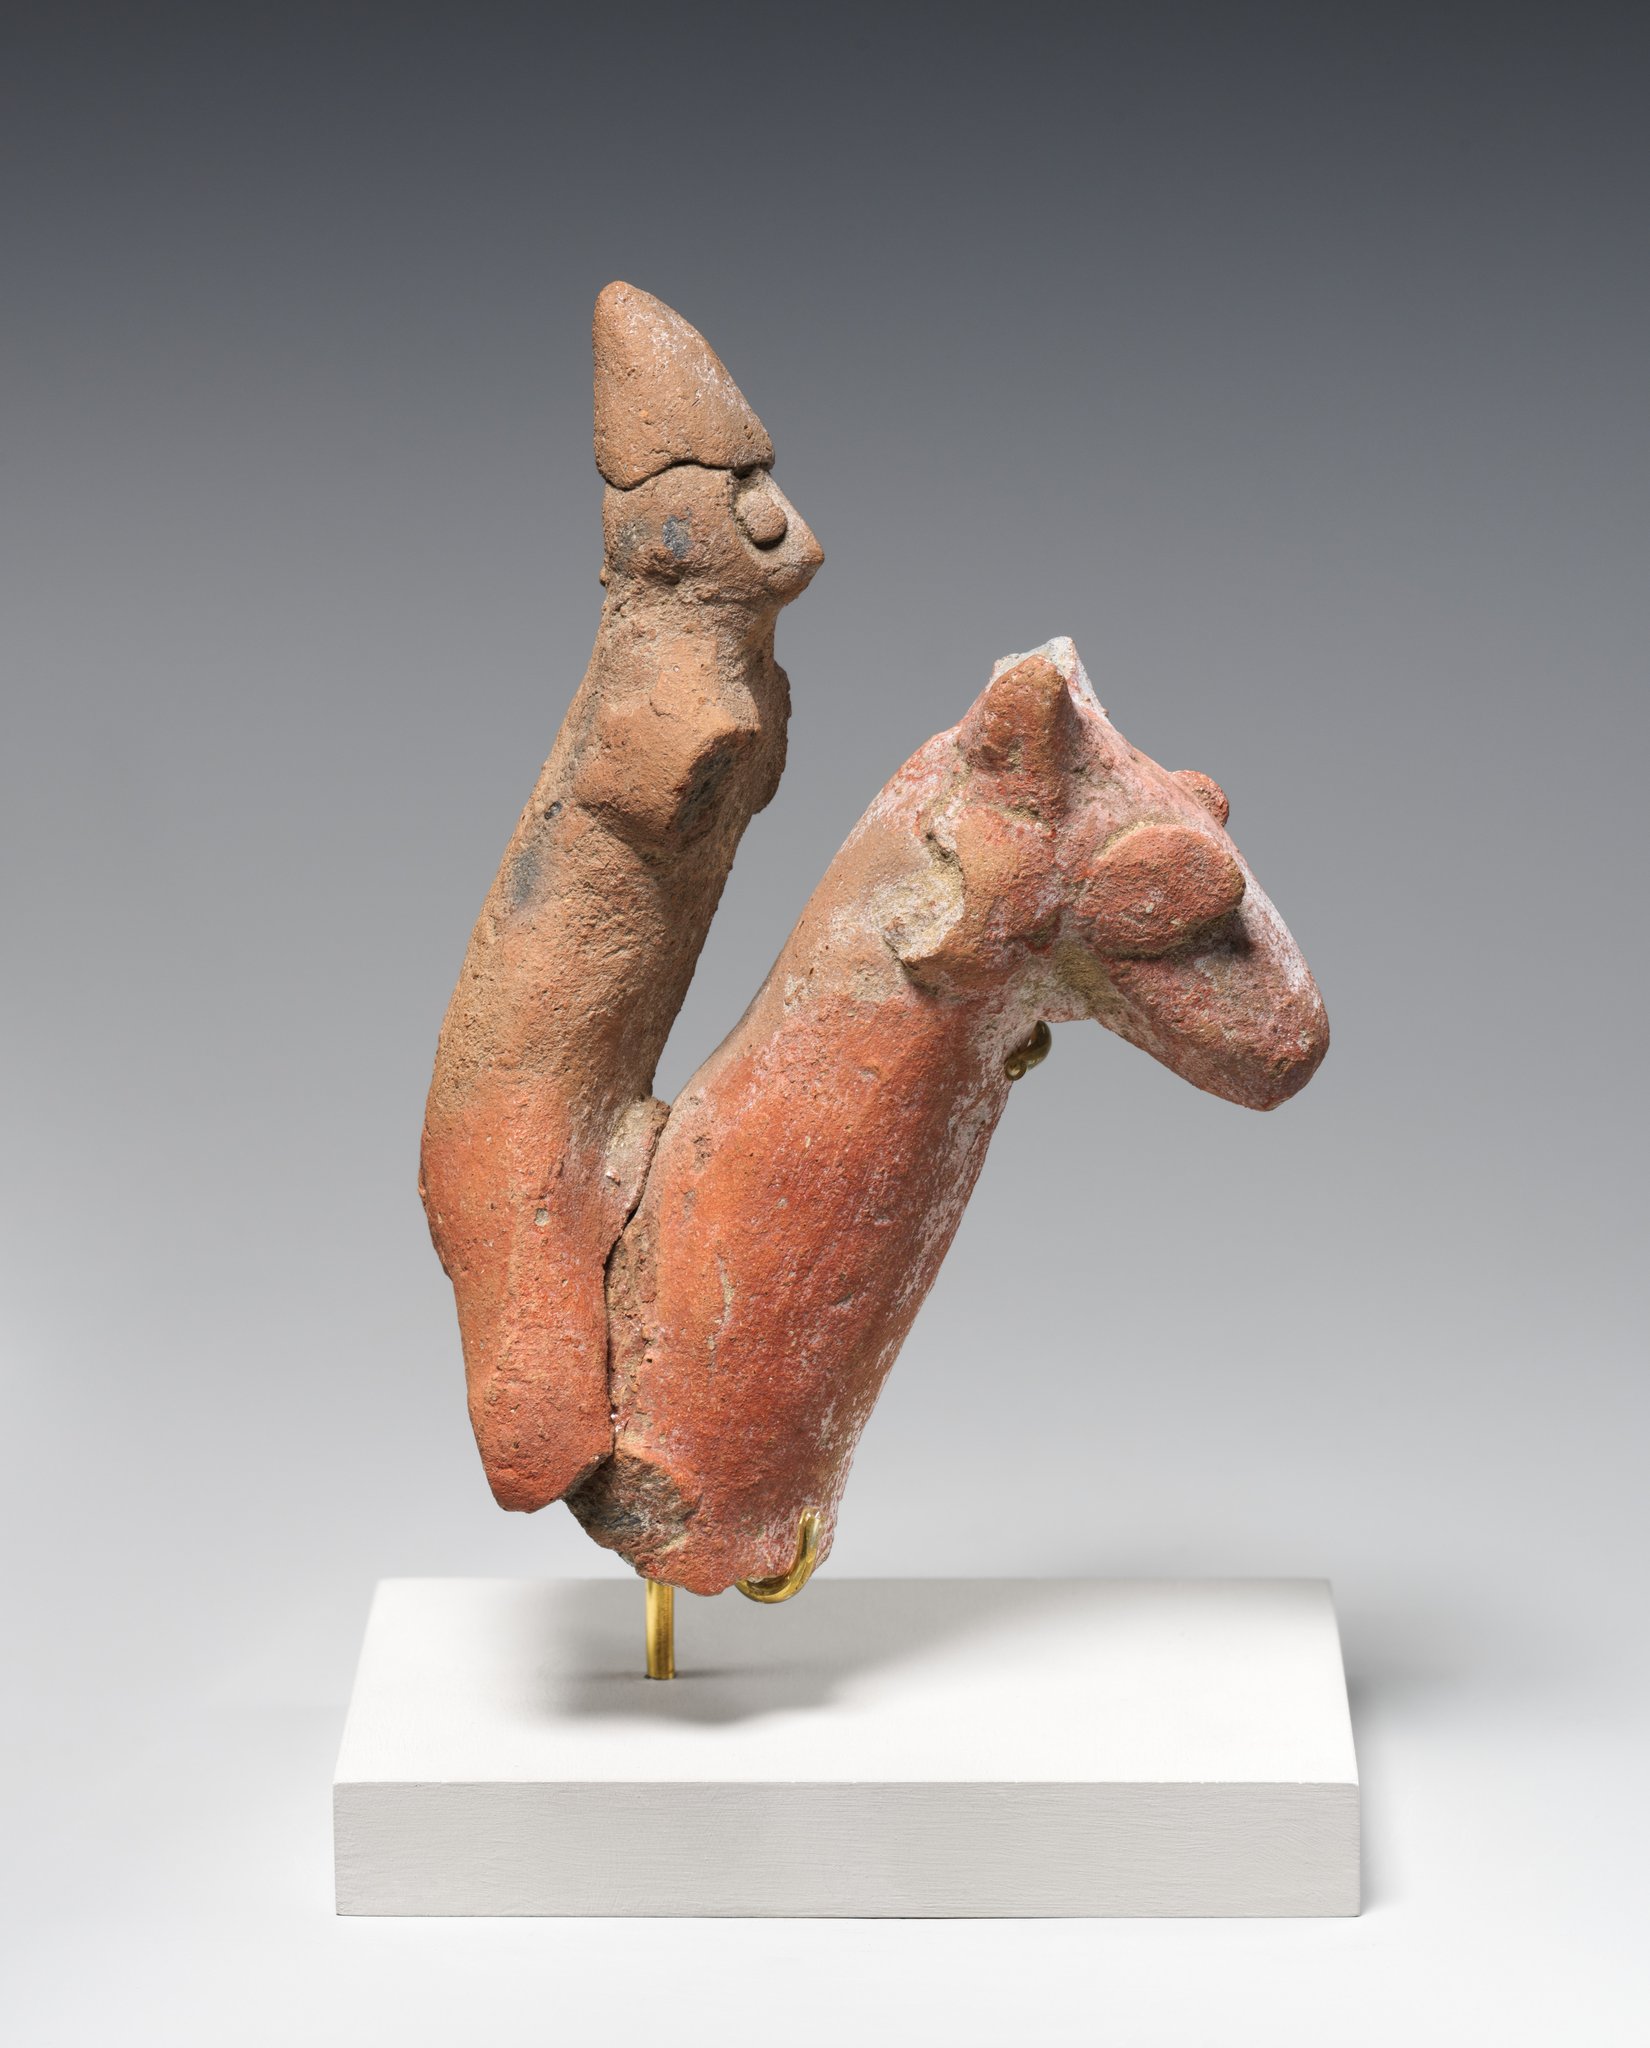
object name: vessel fragment, camel rider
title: Camel Rider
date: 664-332 BCE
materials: pottery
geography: egypt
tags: camels